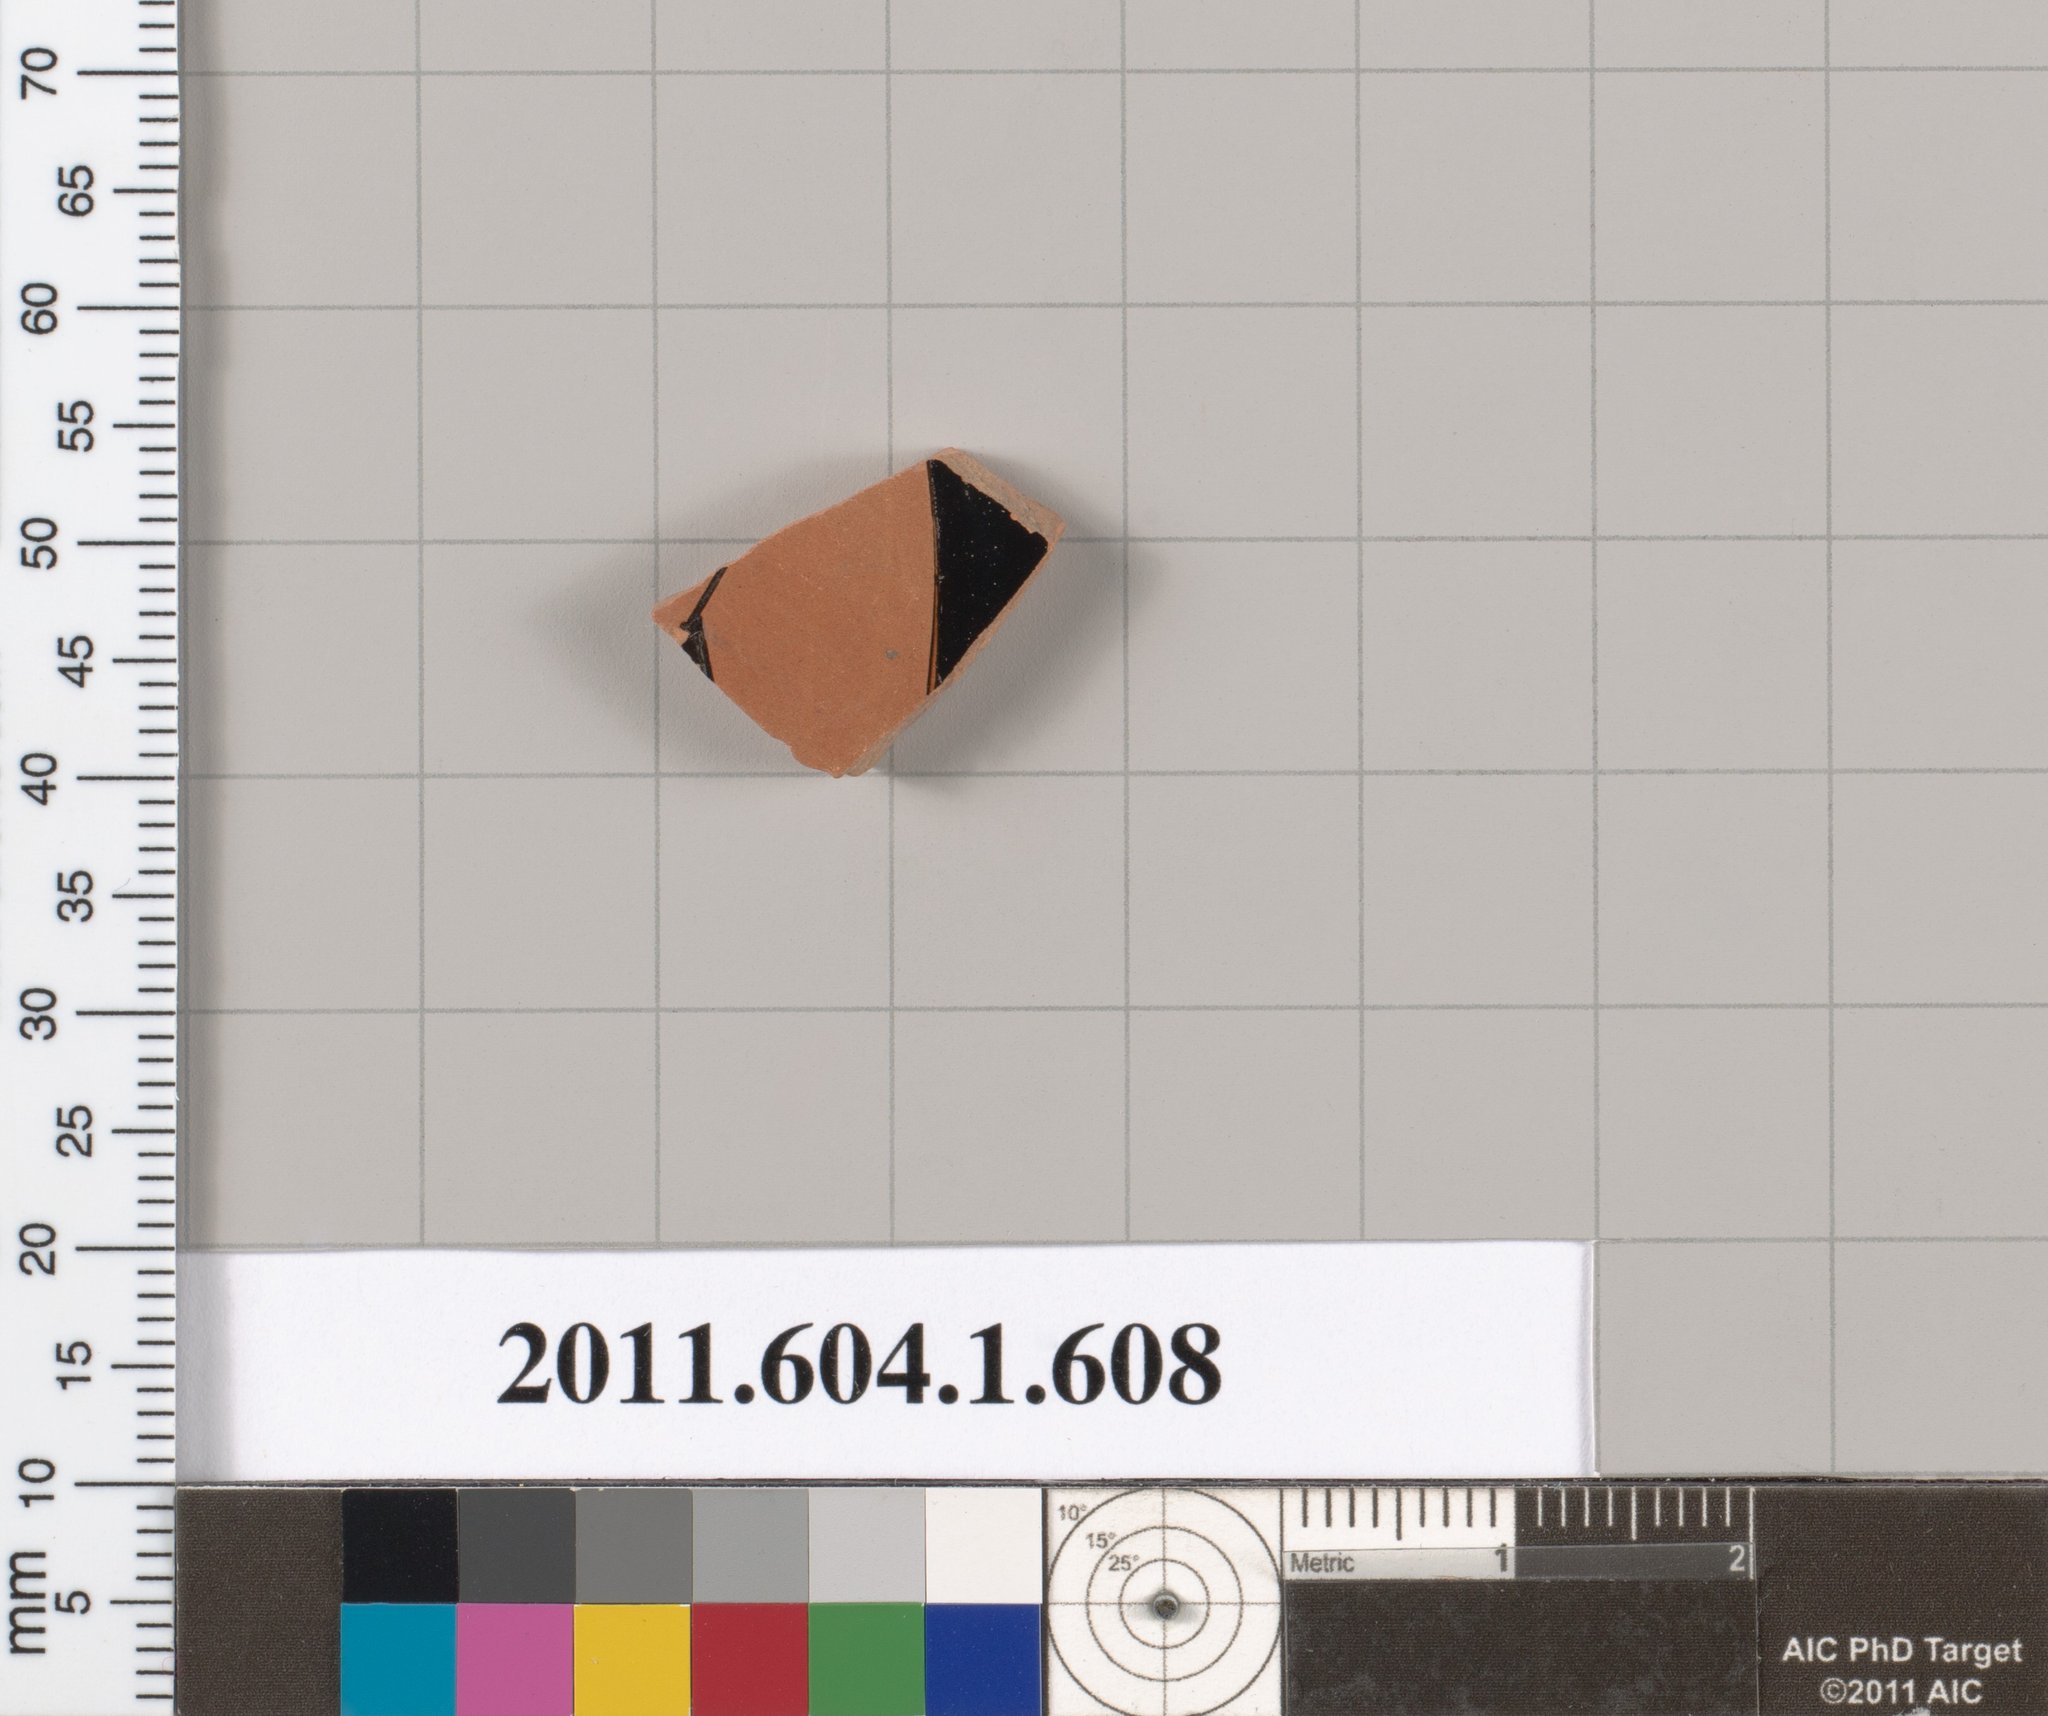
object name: kylix fragment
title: Terracotta fragment of a kylix (drinking cup)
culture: greek, attic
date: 475-451 BCE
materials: terracotta